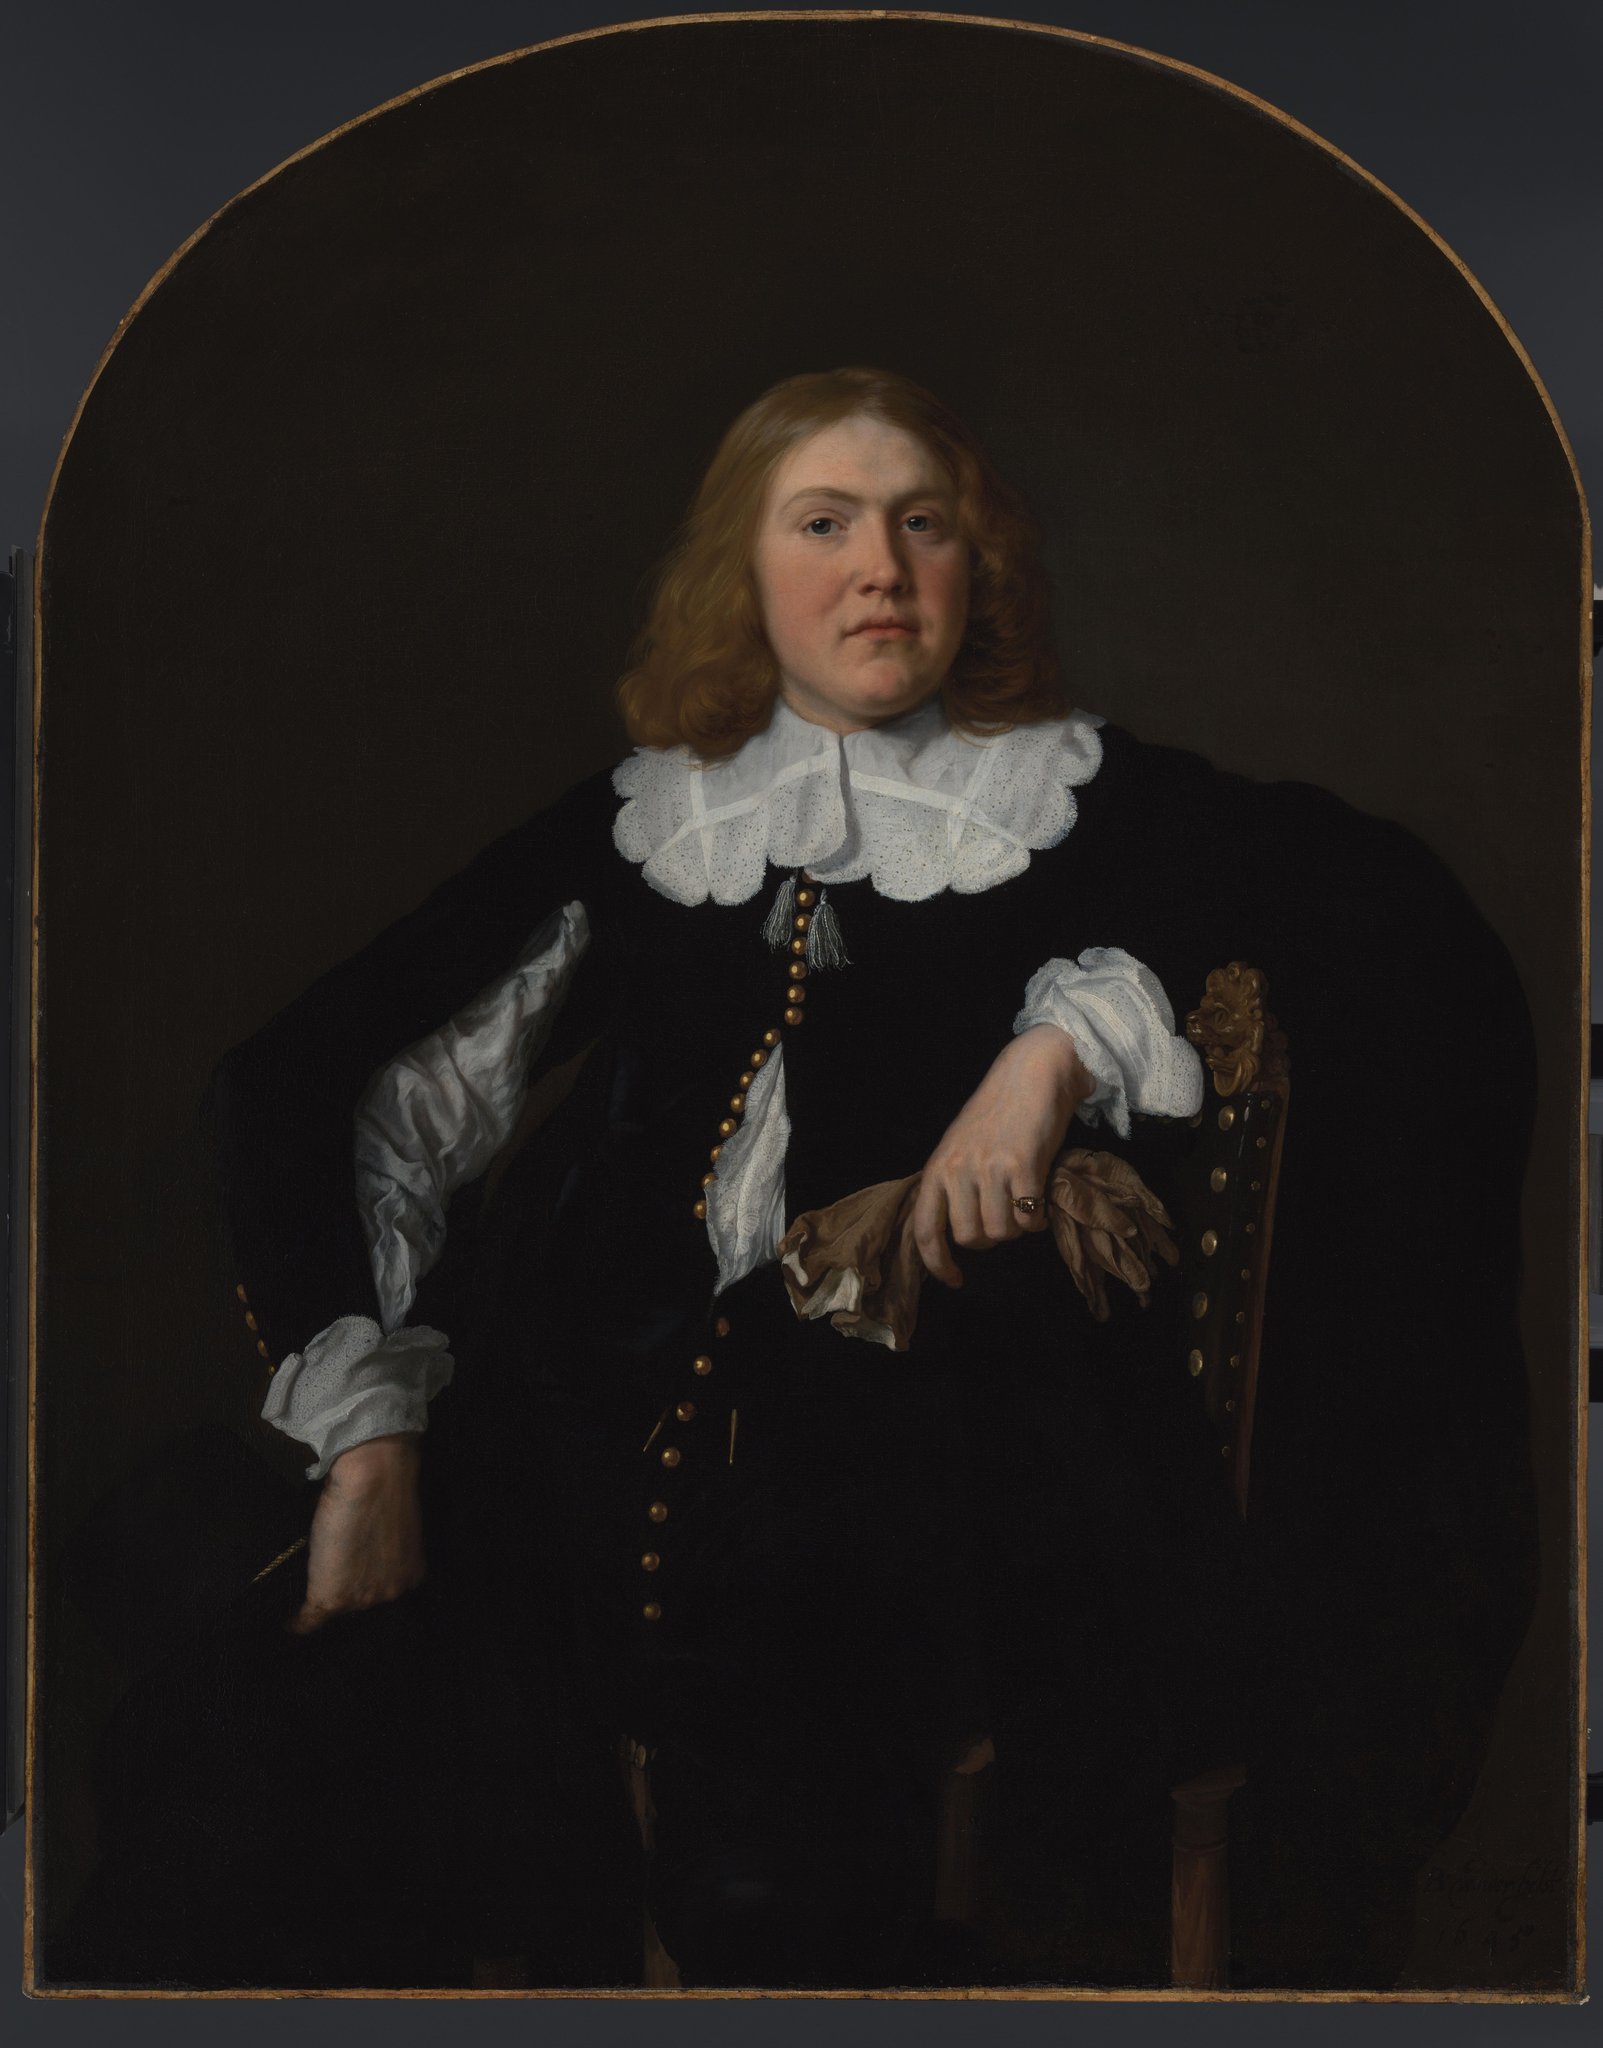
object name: painting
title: Portret van een man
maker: bartholomeus van der helst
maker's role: draughtsman, painter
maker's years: 1613-1670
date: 1645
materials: canvas, oil, paint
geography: netherlands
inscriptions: signature and date: ‘B. Van der Helst 1645’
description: Portret van een zittende jonge man met lang haar, die de beschouwer frontaal aankijkt. Hij is in het zwart gekleed met een witte platte kraag. Hij heeft in zijn linkerhand handschoenen.